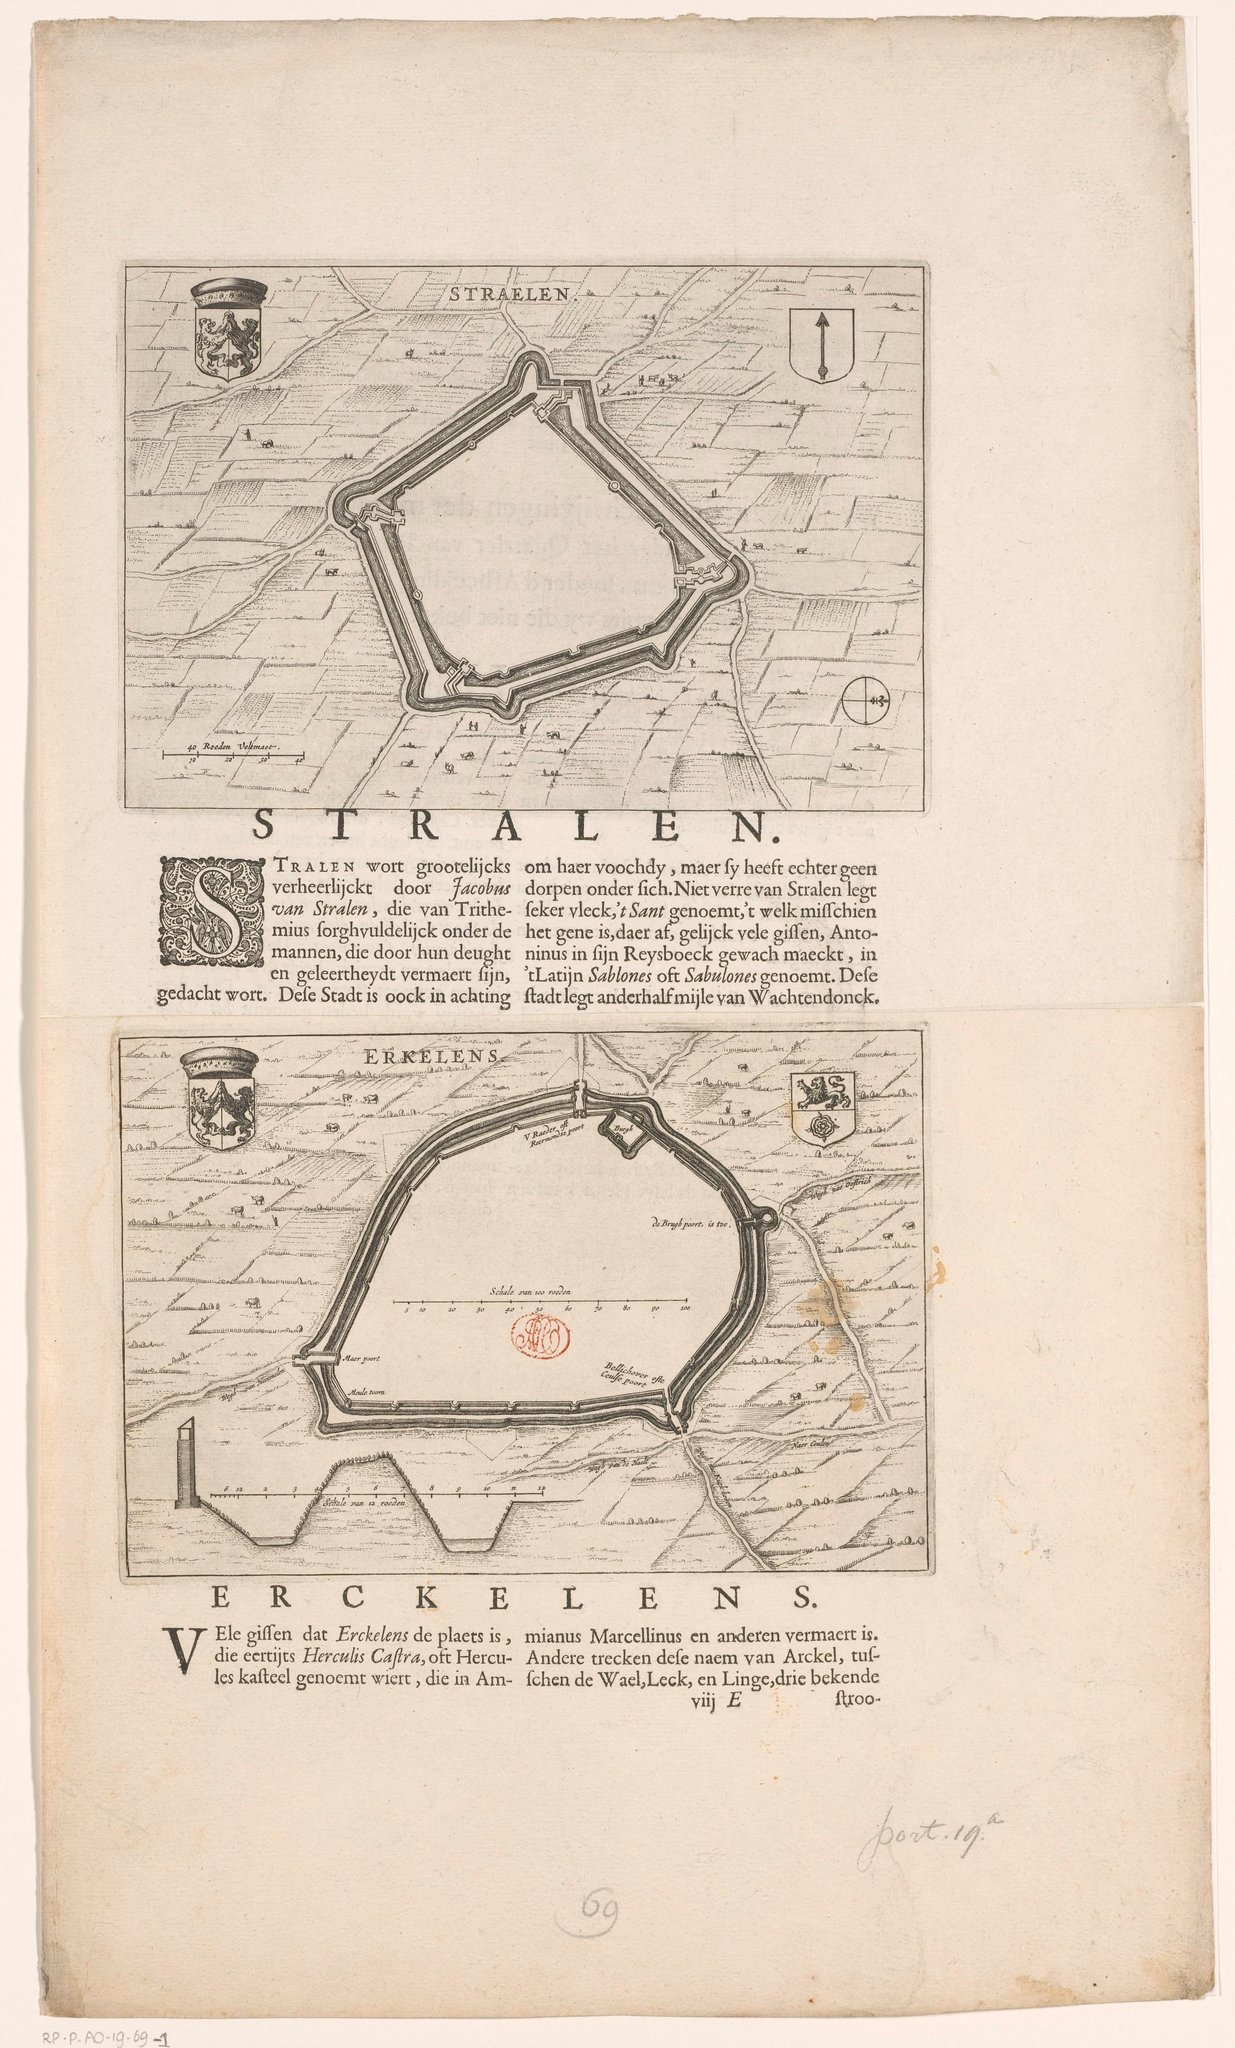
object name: area plan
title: Vestingplattegrond en beschrijving van Straelen en Erkelenz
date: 1652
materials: paper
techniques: engraving, etching, letterpress printing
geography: amsterdam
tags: coat of arms (as symbol of the state, etc.) (+ city; municipal), maps of cities, coat of arms (as symbol of the state, etc.) (+ province; provincial)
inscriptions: collector's mark: Lugt 195, collector's mark: Lugt 2228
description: Boven een plattegrond van Straelen. Linksboven het wapen van het hertogdom Gelre, rechtsboven het wapen van Straelen. Linksonder een schaalstok: 40 Roeden Veltmaet. Hieronder een beschrijving van Straelen in het Nederlands. Onder een vestingplattegrond van Erkelenz. Linksboven het wapen van het hertogdom Gelre, rechtsboven het wapen van Erkelenz. Linksonder een doorsnede van de wal voor de vesting, met schaalstok: Schale van 12 roeden. Hieronder een beschrijving van Erkelenz in het Nederlands. Met Nederlandse tekst op verso.